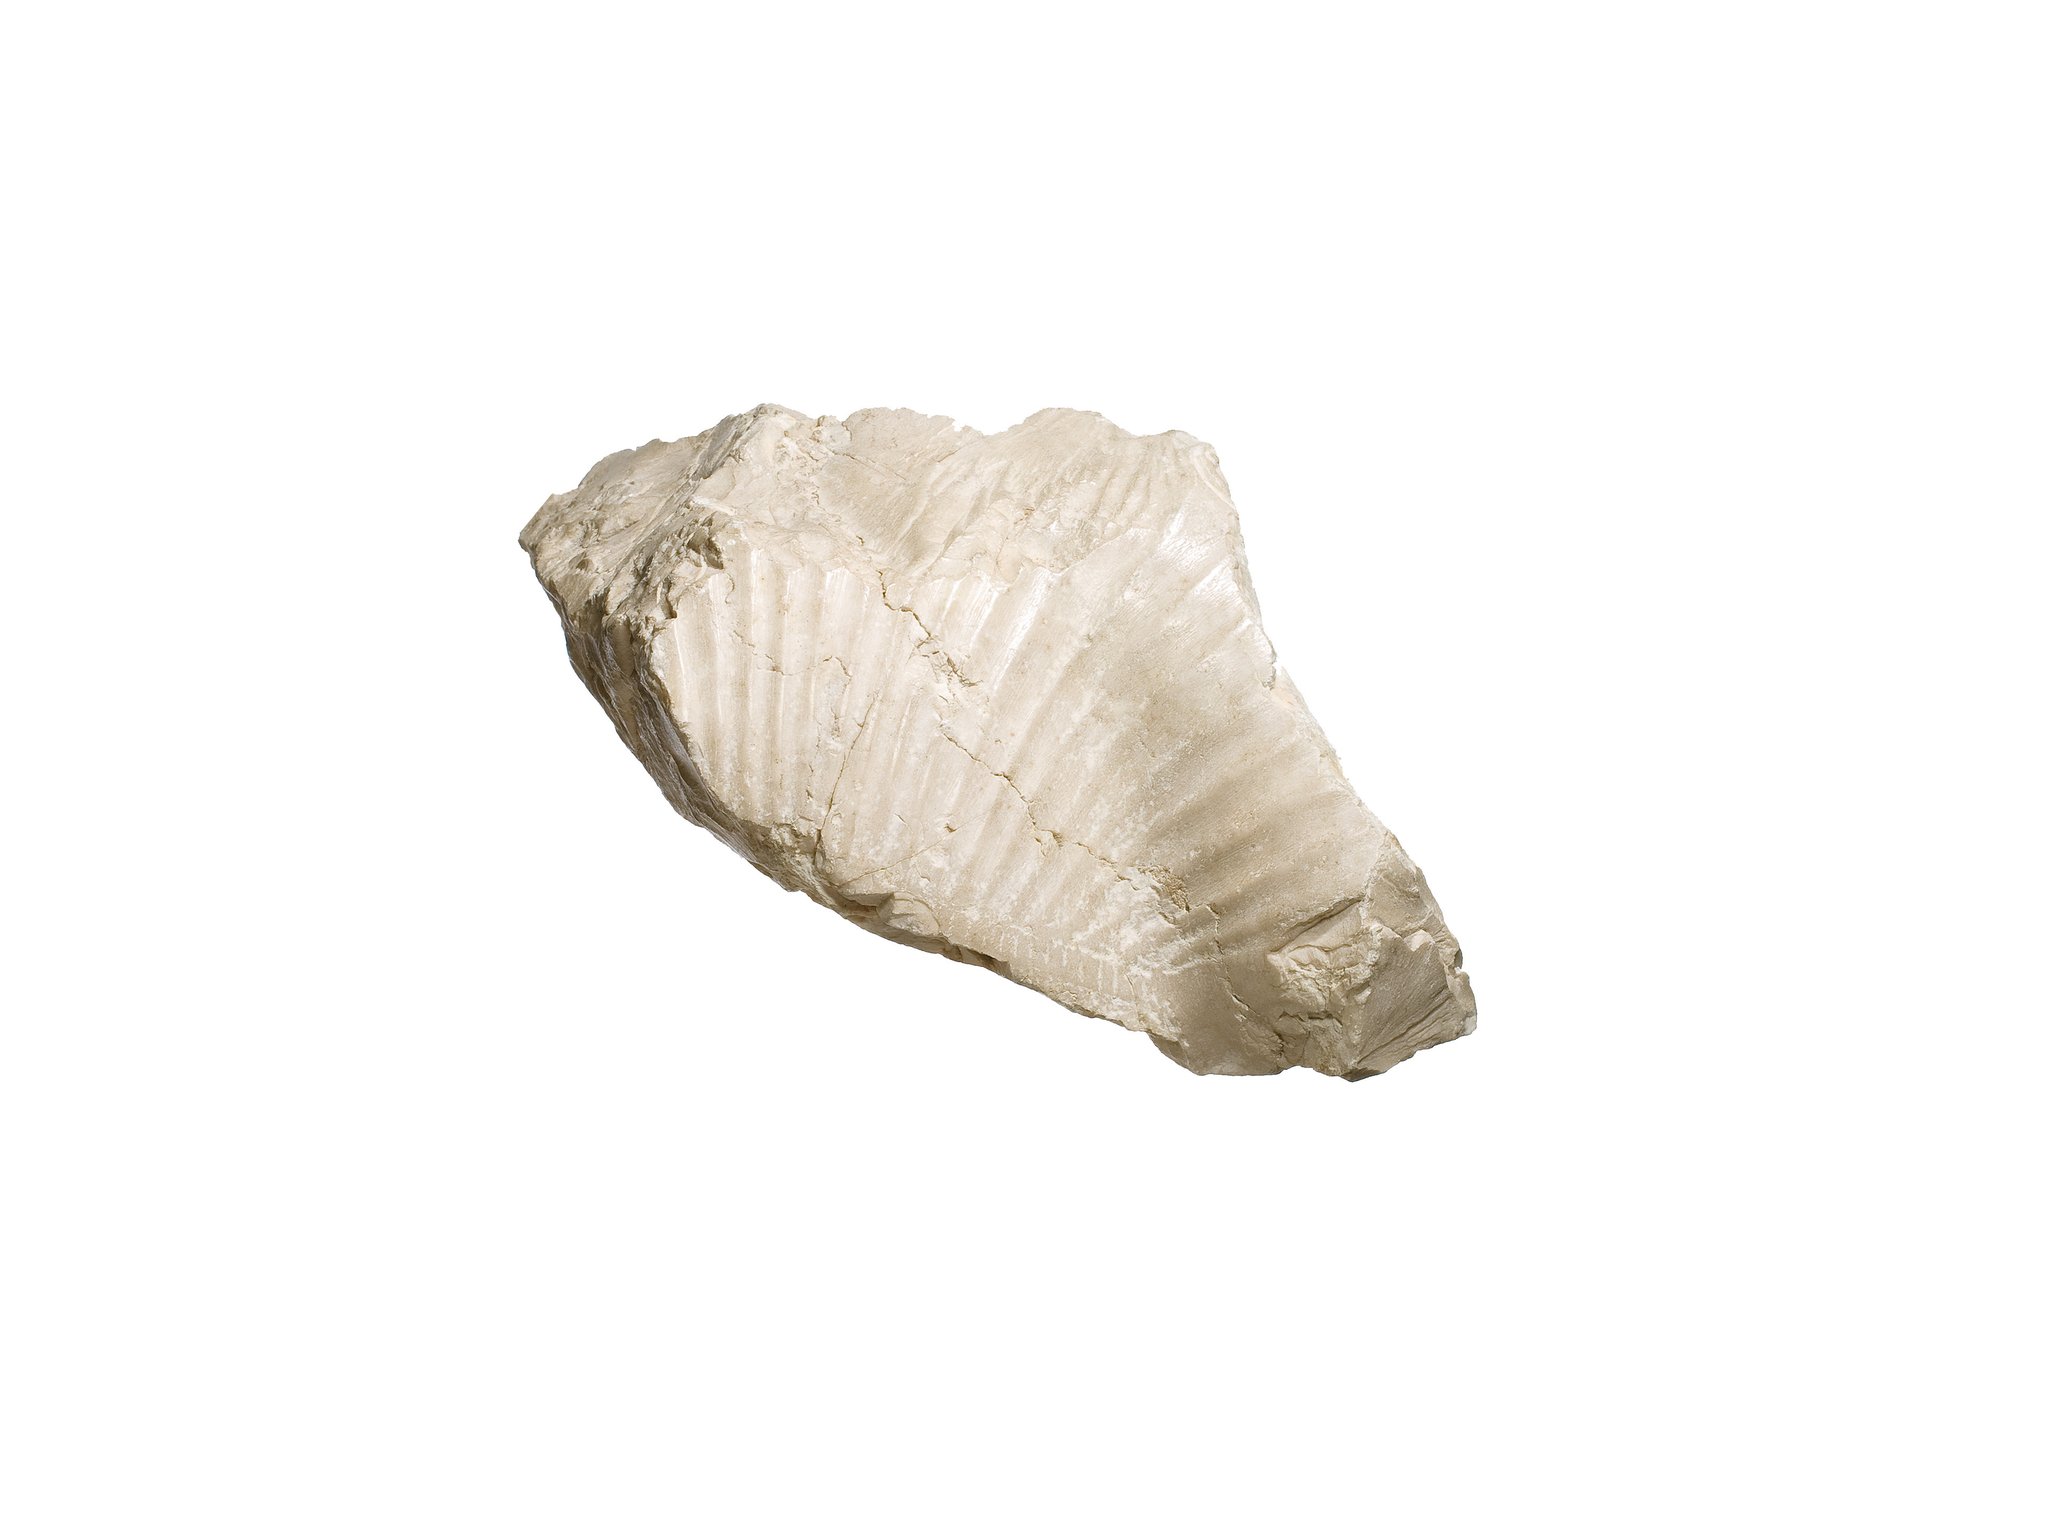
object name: nefertiti, breast and shoulder, cartouche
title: Nefertiti breast and shoulder fragment, cartouche [of Aten]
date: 1352-1336 BCE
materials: limestone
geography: egypt